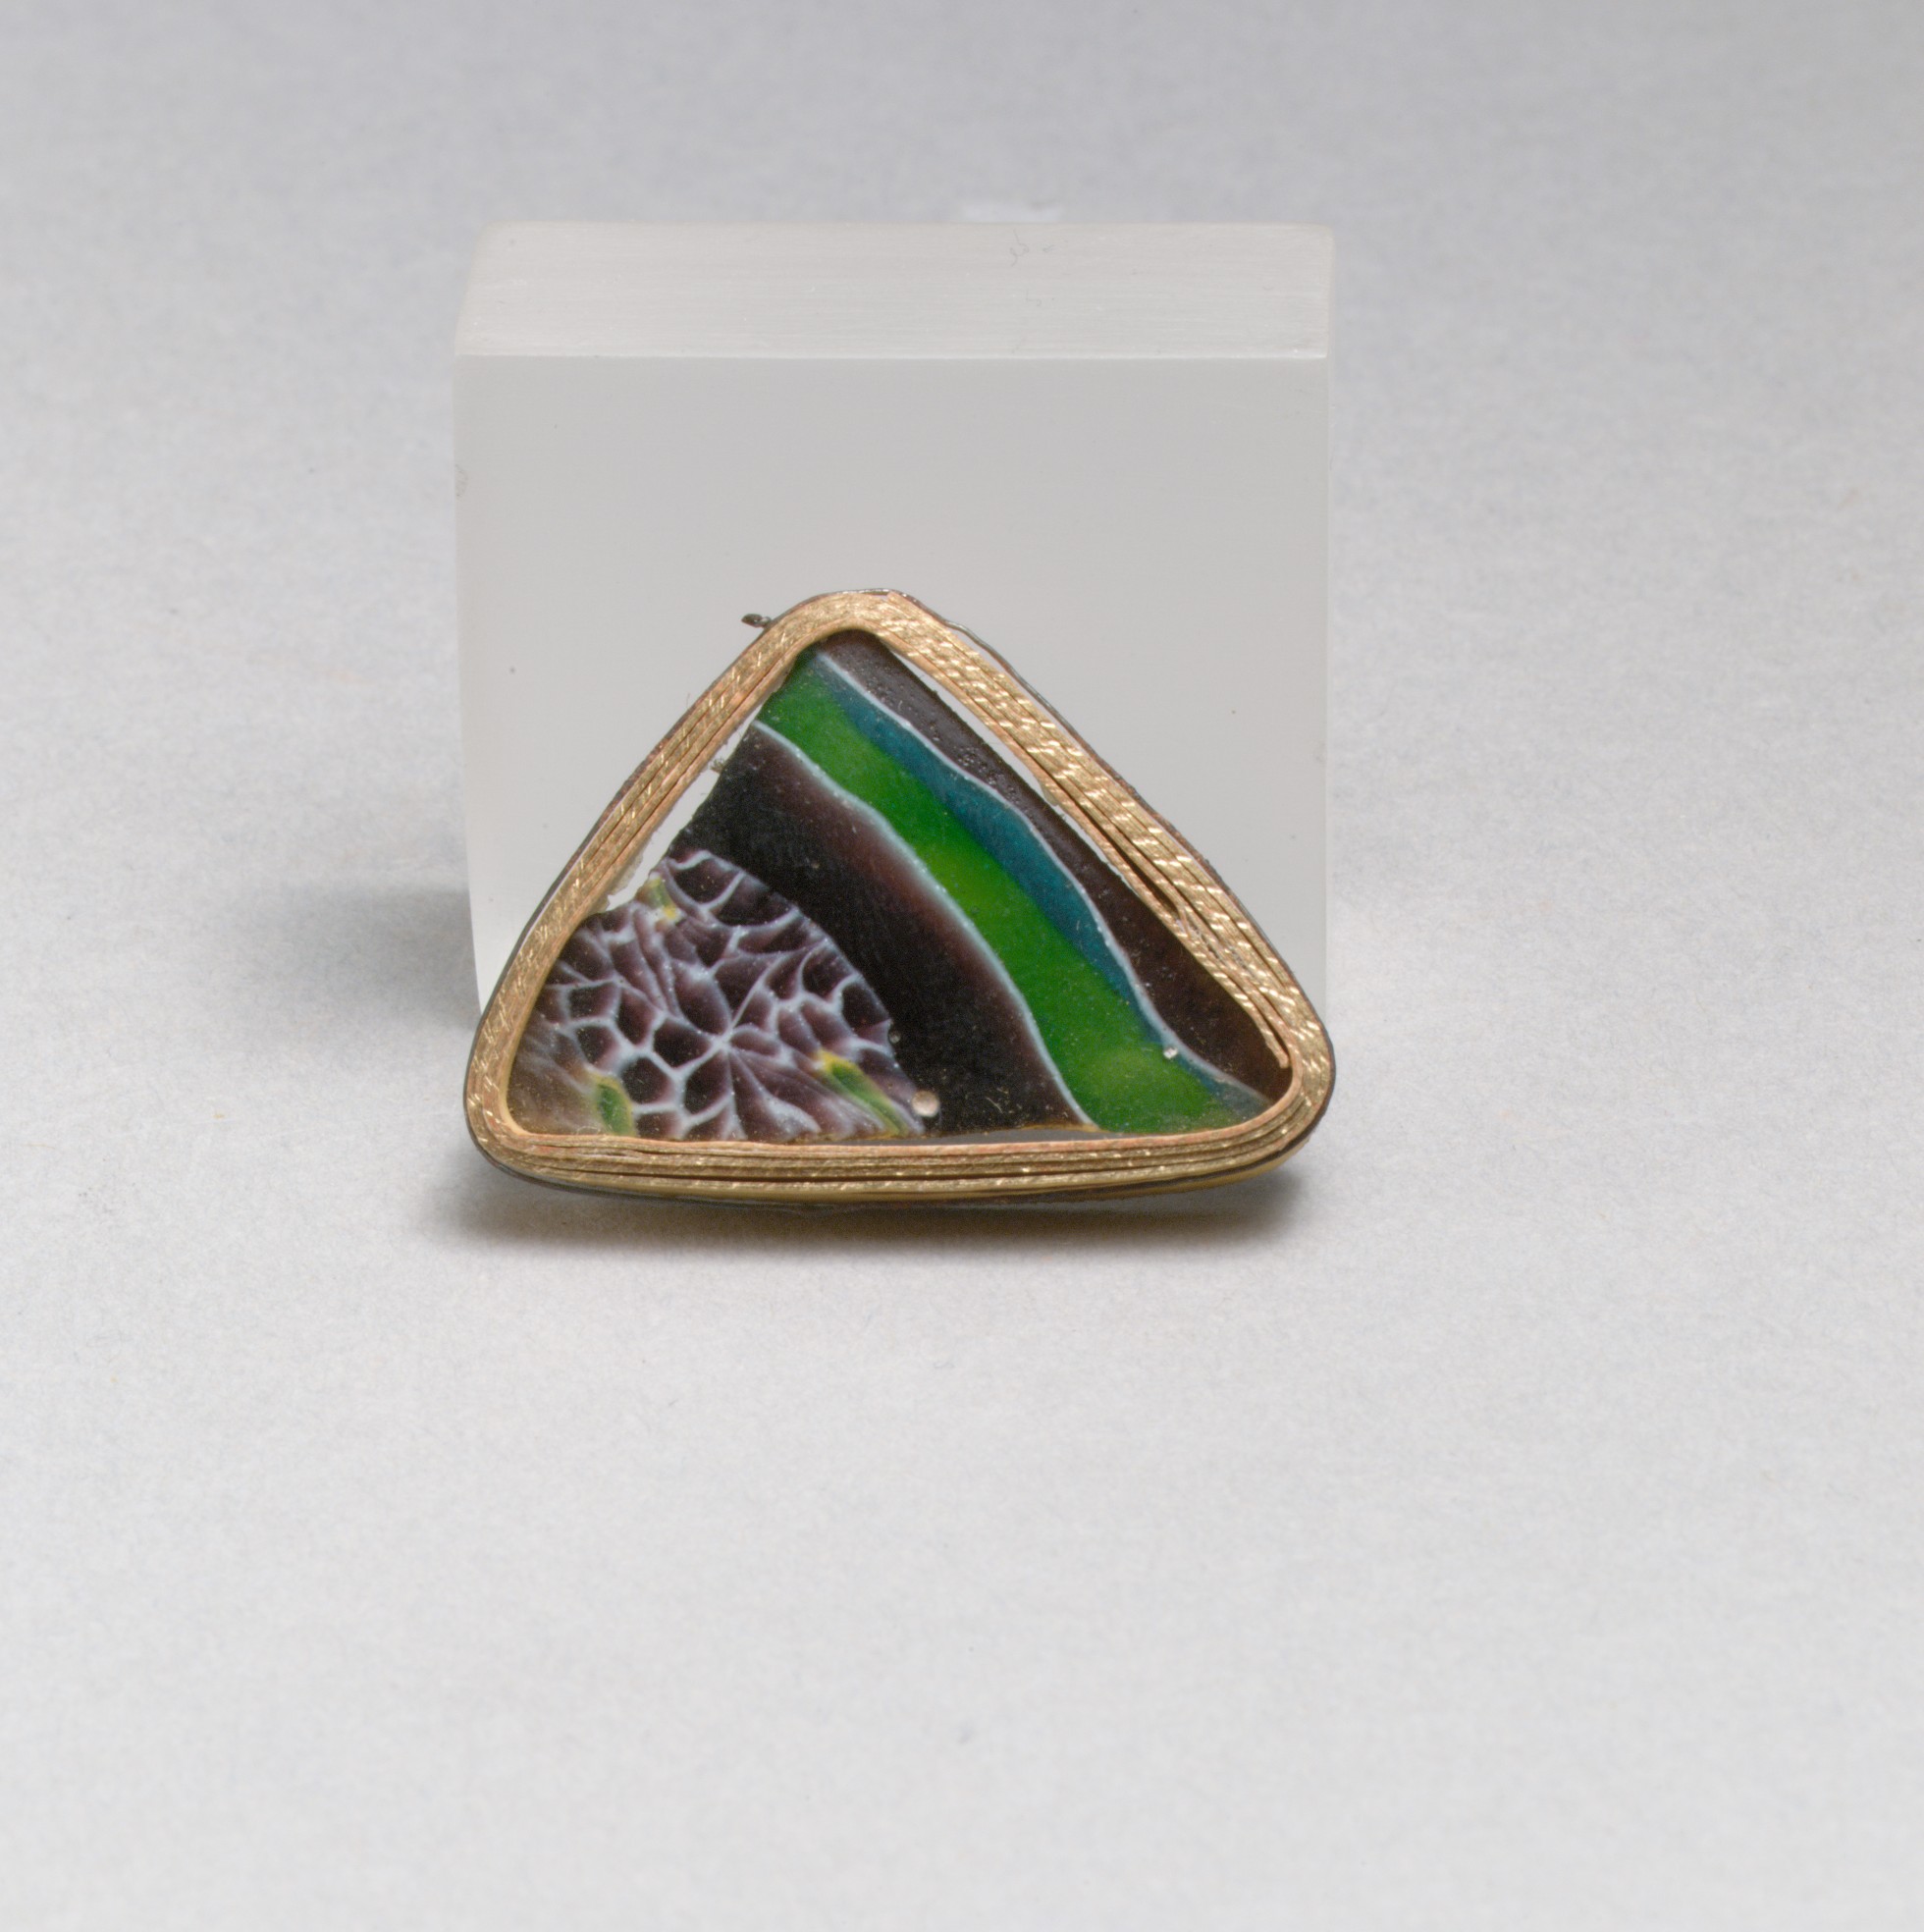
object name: fragment, mosaic bowl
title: Glass mosaic bowl fragment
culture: roman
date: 34 BCE-33 CE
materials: glass